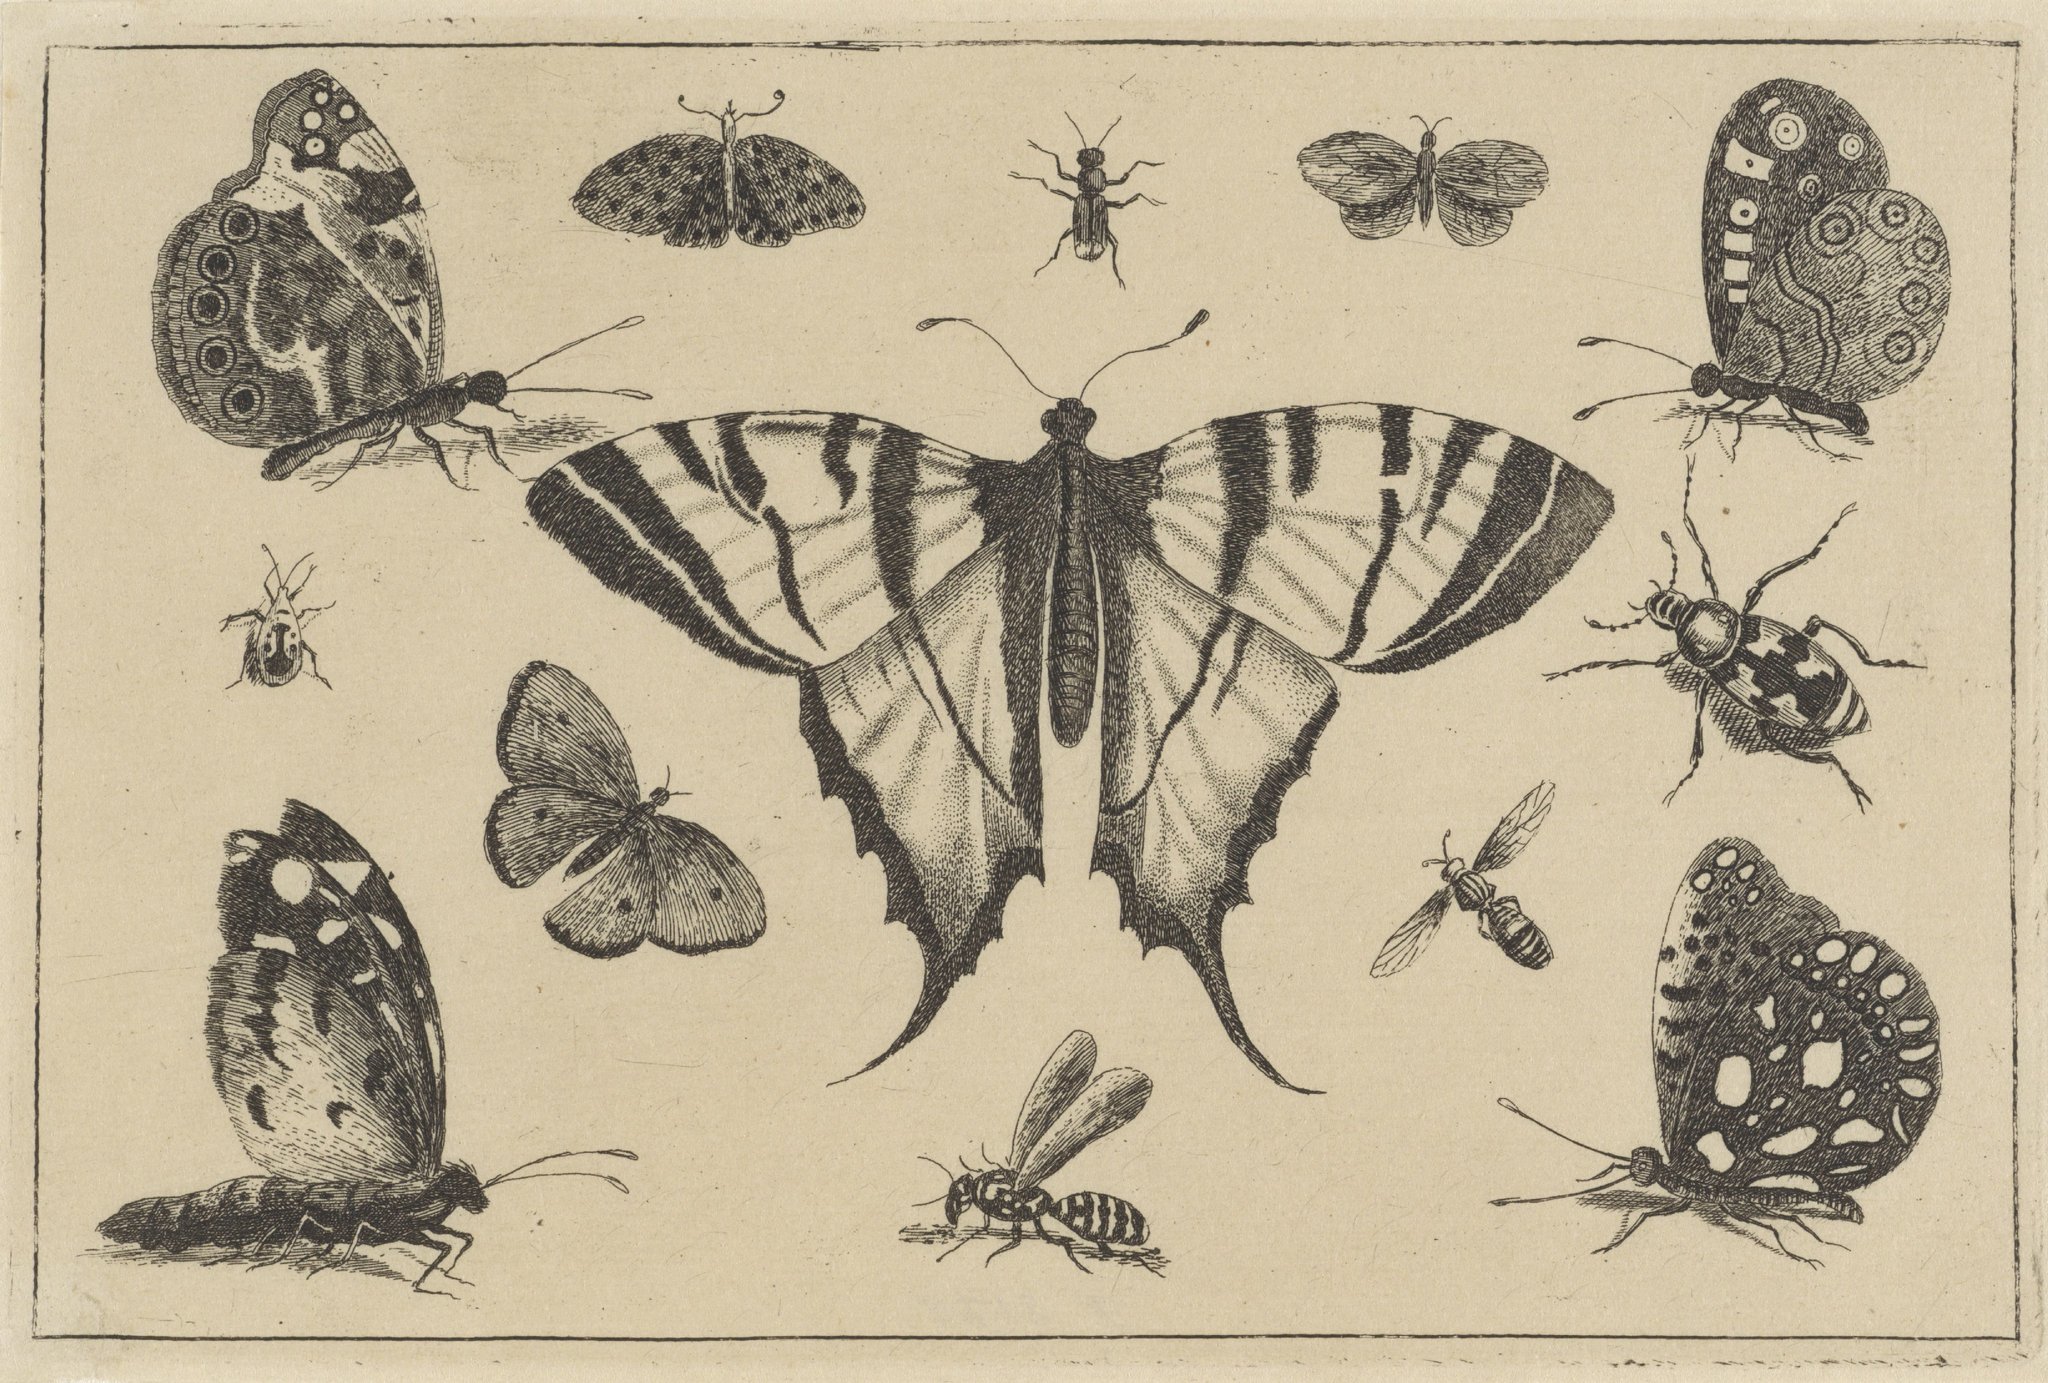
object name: print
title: Vlinders, wesp en andere insekten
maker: wenceslaus hollar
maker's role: draughtsman, print maker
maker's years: 1607-1677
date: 1644-1652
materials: paper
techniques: etching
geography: antwerp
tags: insects: wasp, insects: butterfly, insects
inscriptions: collector's mark: Lugt 2900, collector's mark: Lugt 2773, collector's mark: Lugt 975, collector's mark: Lugt 2228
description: Prent maakt deel uit van de achtdelige serie (incl. titelprent) met verschillende insecten: "Diversae Insectorum".